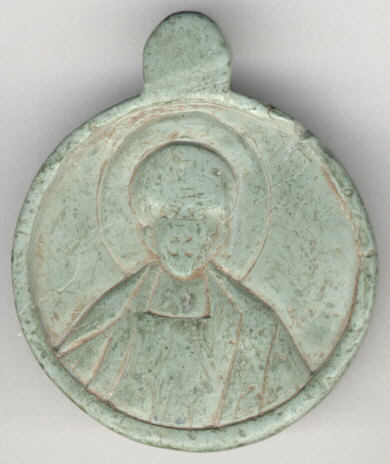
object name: pendant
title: Medallion with the Head of a Saint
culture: byzantine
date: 1301-1500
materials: stone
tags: medallions,men,saints